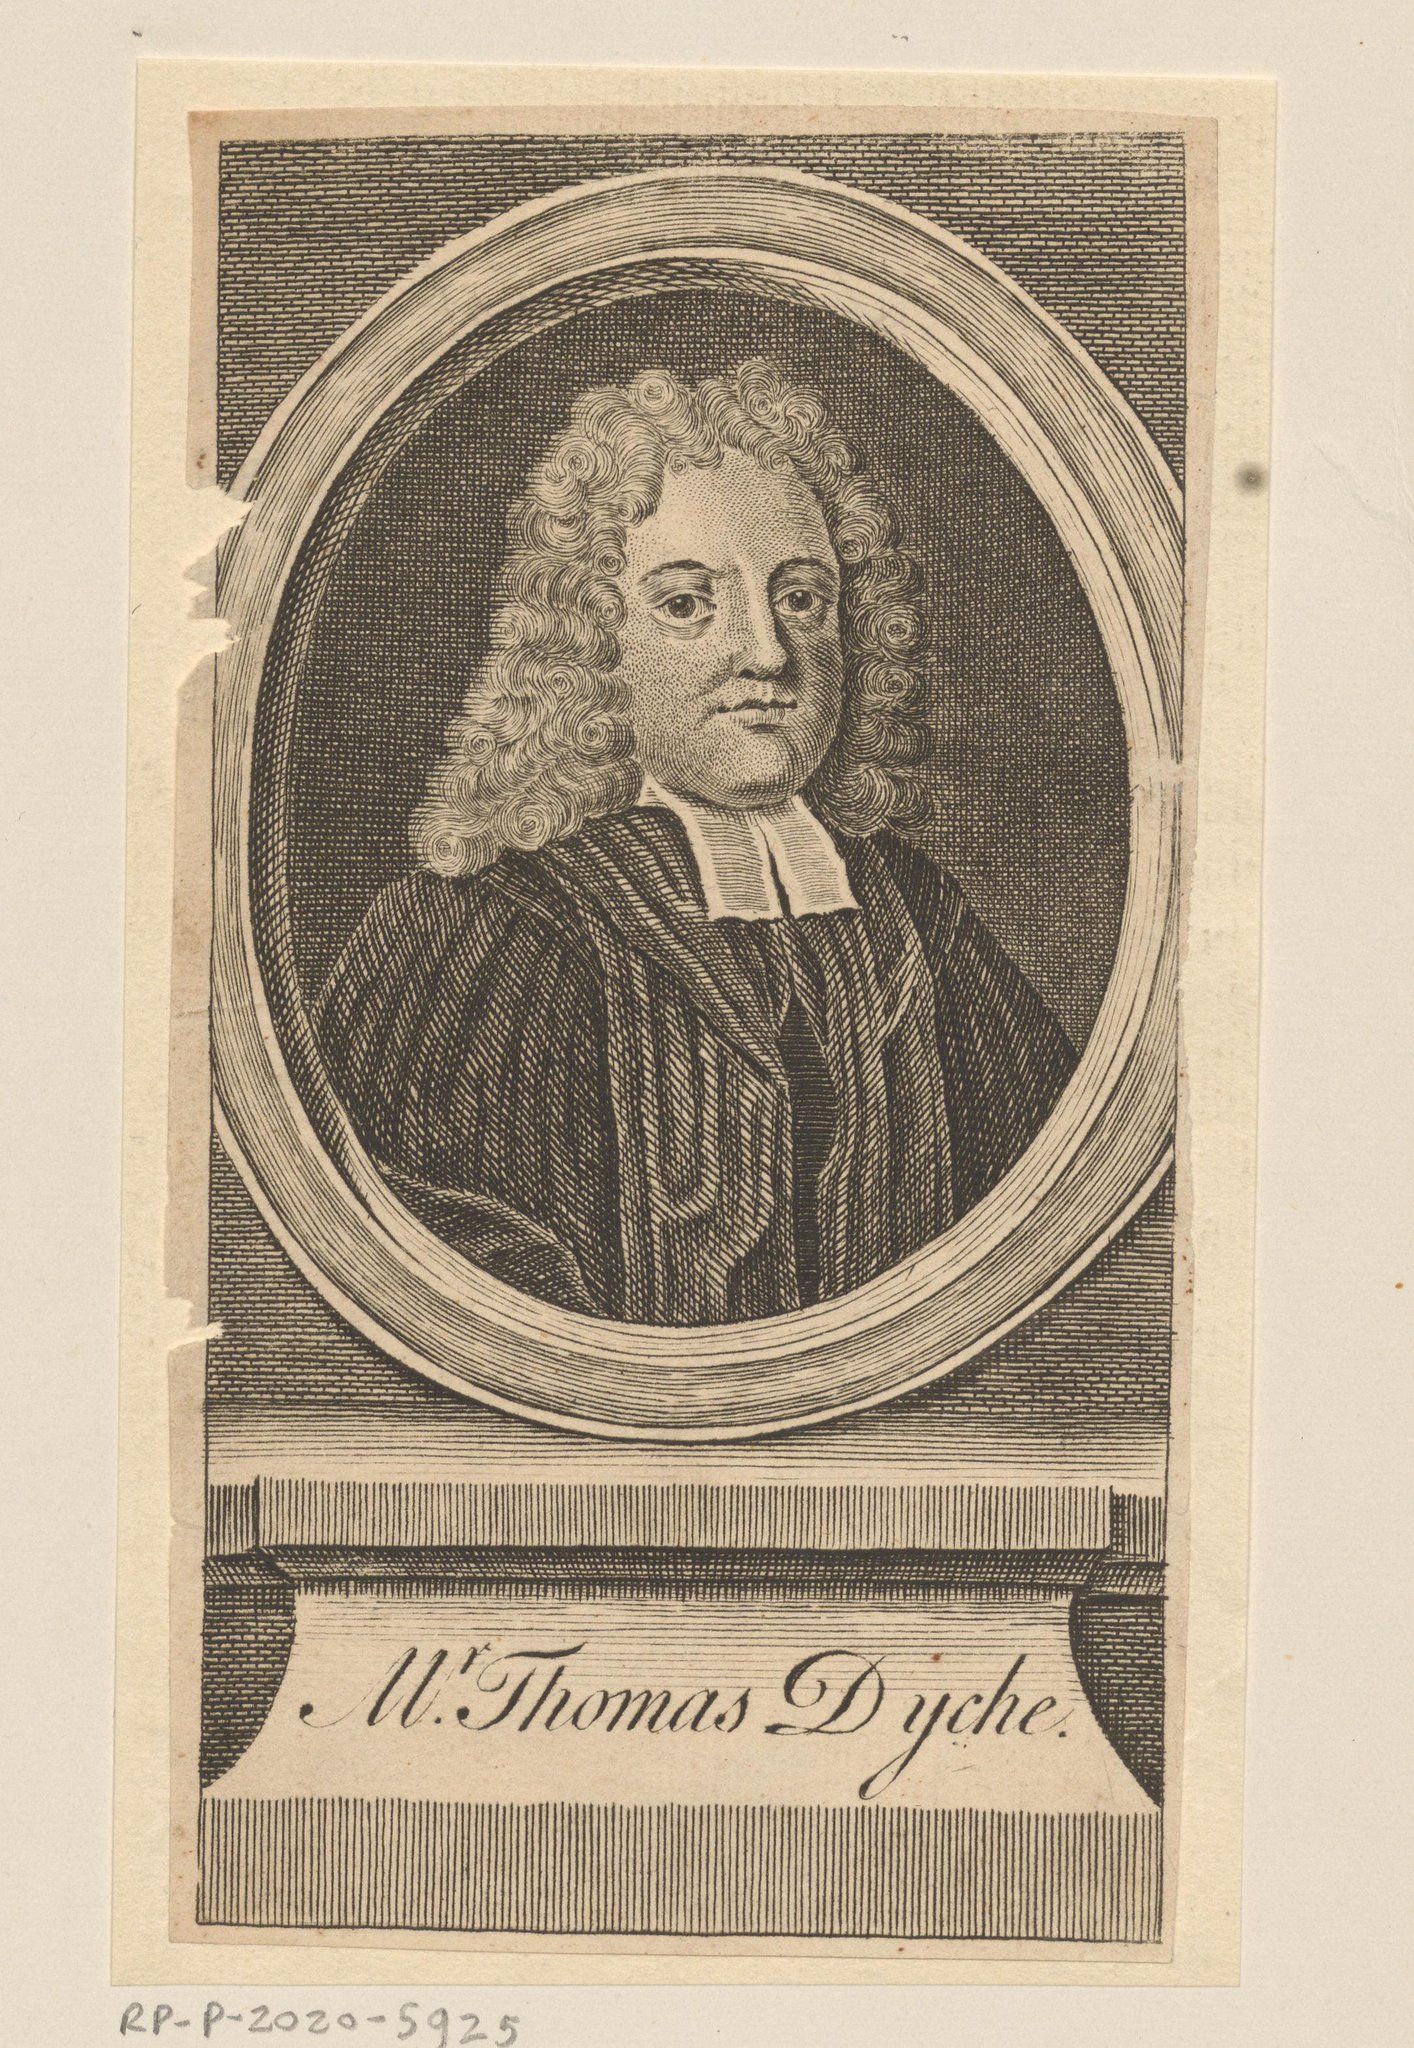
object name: print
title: Portret van Thomas Dyche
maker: Anonymous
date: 1700-1799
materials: paper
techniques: engraving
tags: historical persons, portrait of a writer